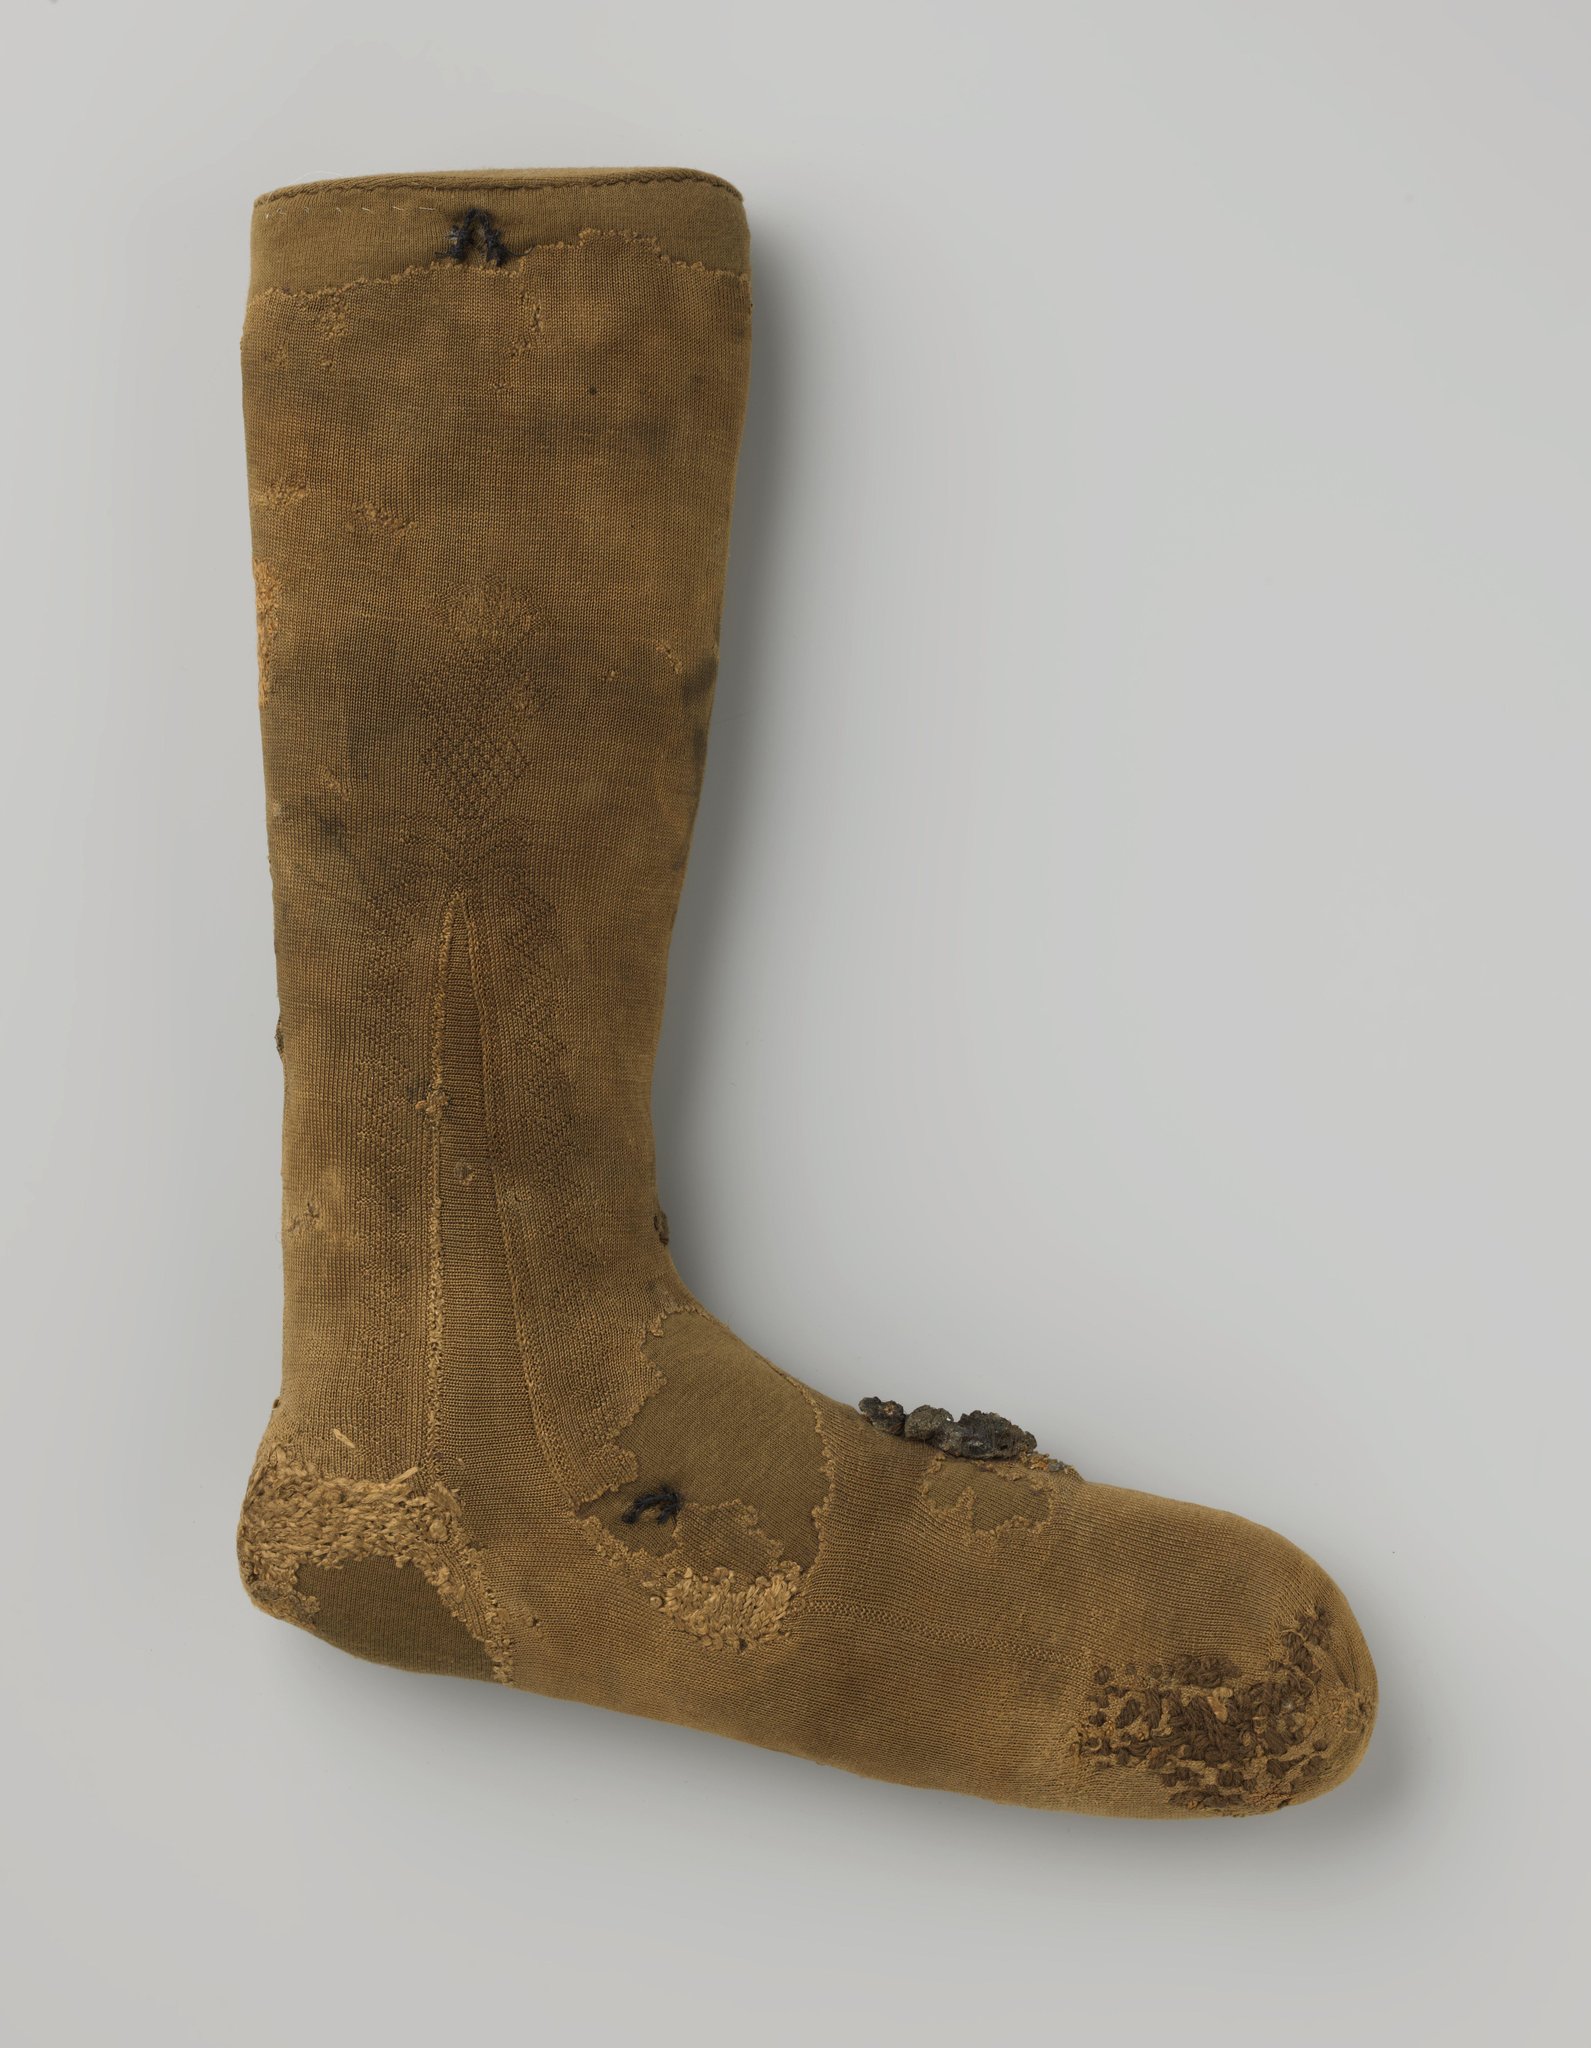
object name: stocking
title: Man's silk stocking from the wreck of the Dutch East Indiaman 't Vliegend Hart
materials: silk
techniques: embroidered, weave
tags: 't vliegend hart (schip), verenigde oostindische compagnie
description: Bijna complete zijden kous waarop een patroon is geborduurd. Met verschillende stoppen.